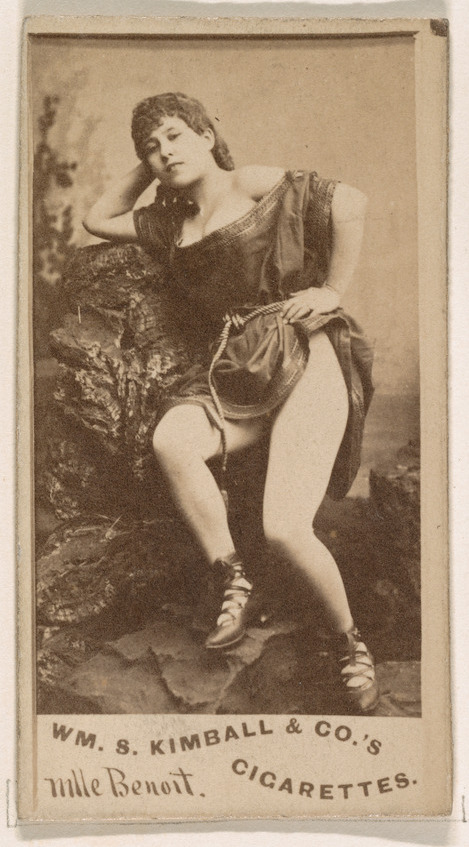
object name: photograph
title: Mlle. Benoit, from the Actresses series (N203) issued by Wm. S. Kimball & Co.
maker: william s. kimball & company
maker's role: publisher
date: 1889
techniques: color lithograph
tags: portraits,women,actresses